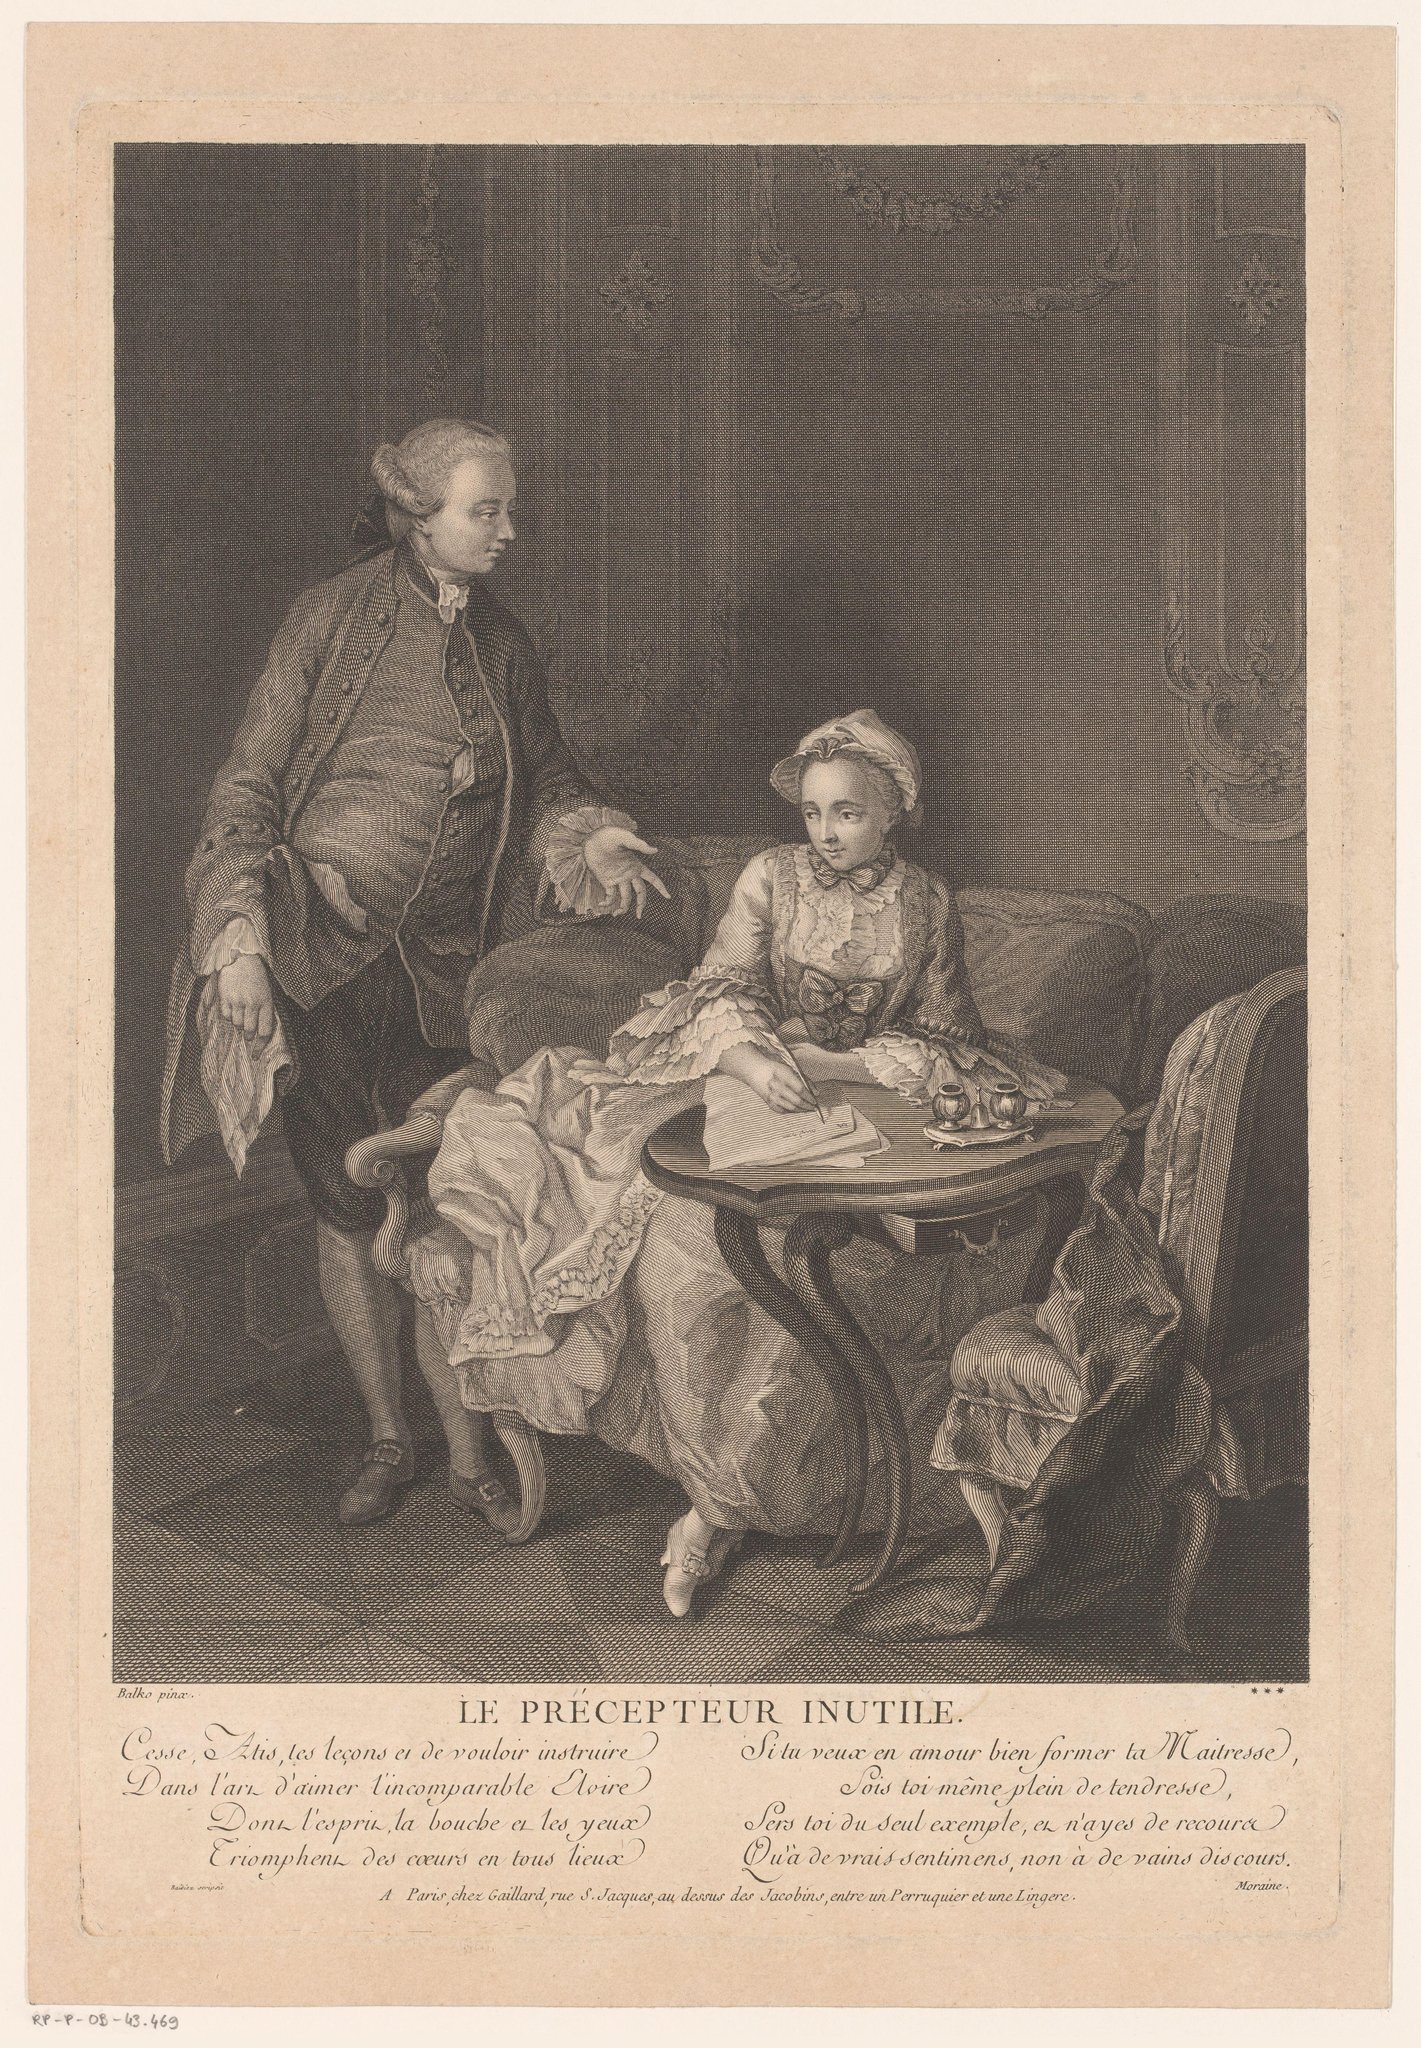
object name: print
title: Le Précepteur inutile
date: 1729-1790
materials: paper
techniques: engraving, etching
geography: paris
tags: teacher and pupil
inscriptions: collector's mark: Lugt 2228